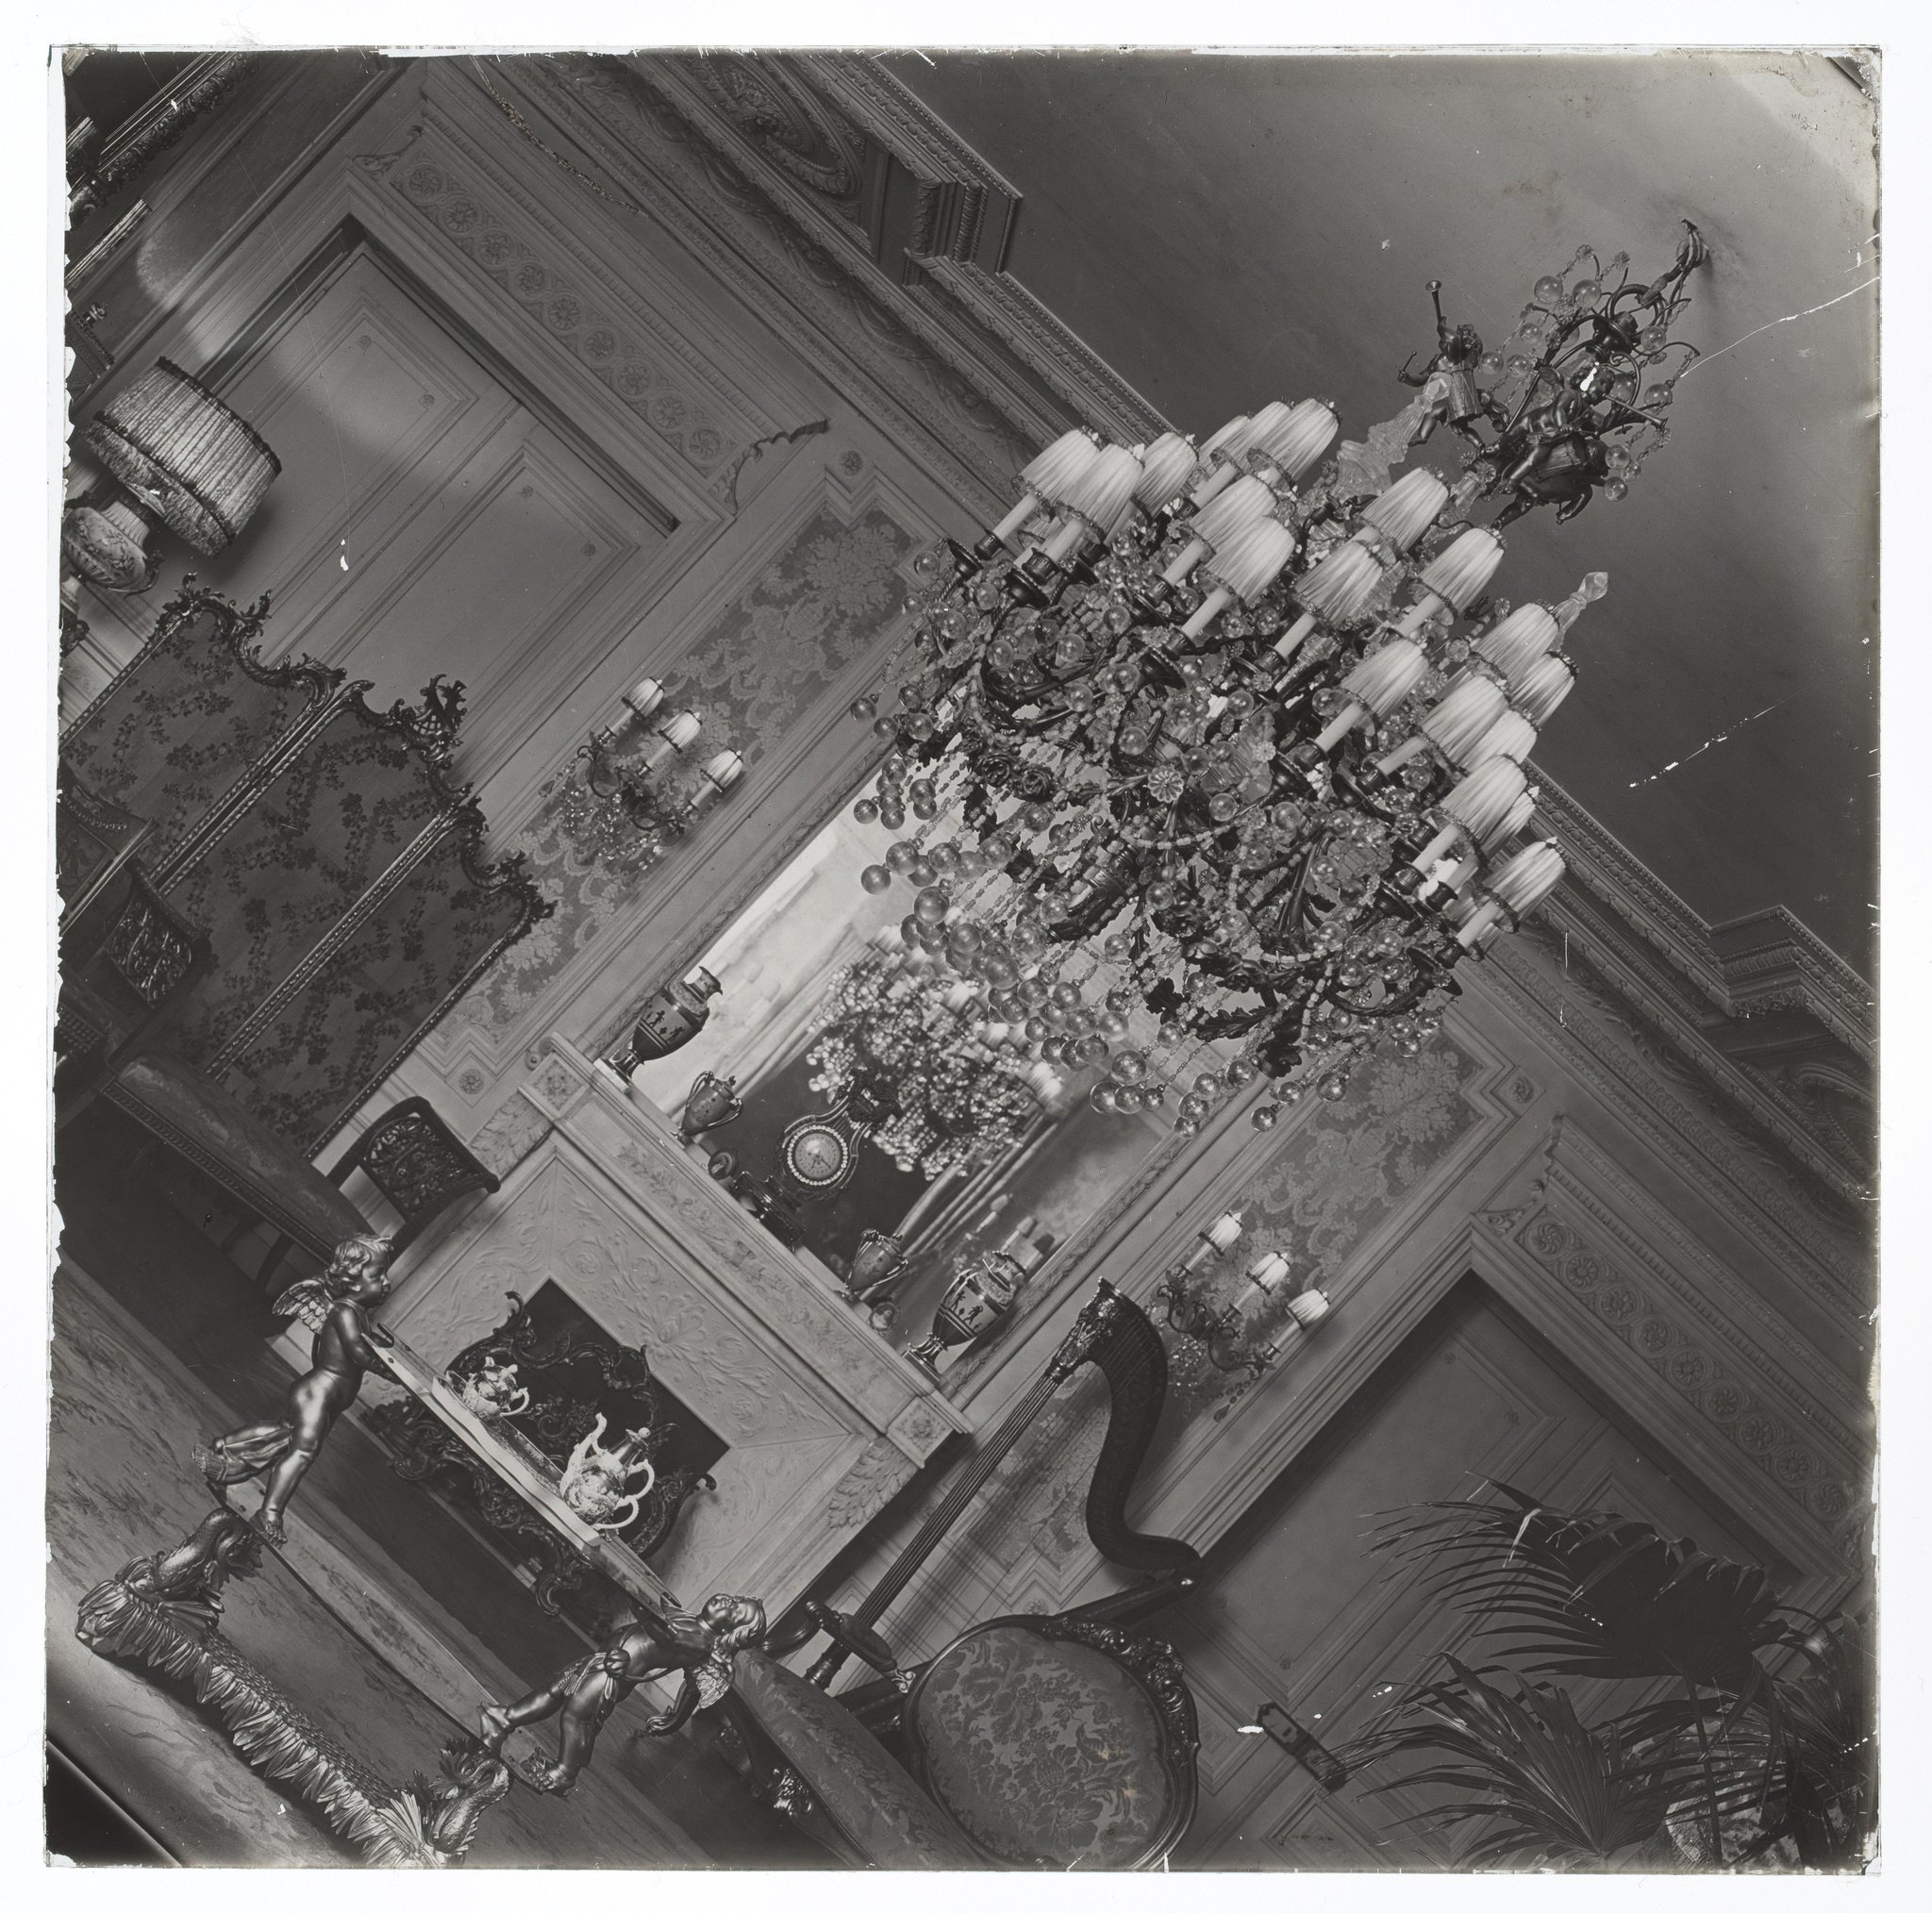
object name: sheet glass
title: Interieur van een kamer met kamerscherm, harp en kroonluchter, opname 45 graden gedraaid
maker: Anonymous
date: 1870-1920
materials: glass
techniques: collodion process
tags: living-room, parlour, sitting-room